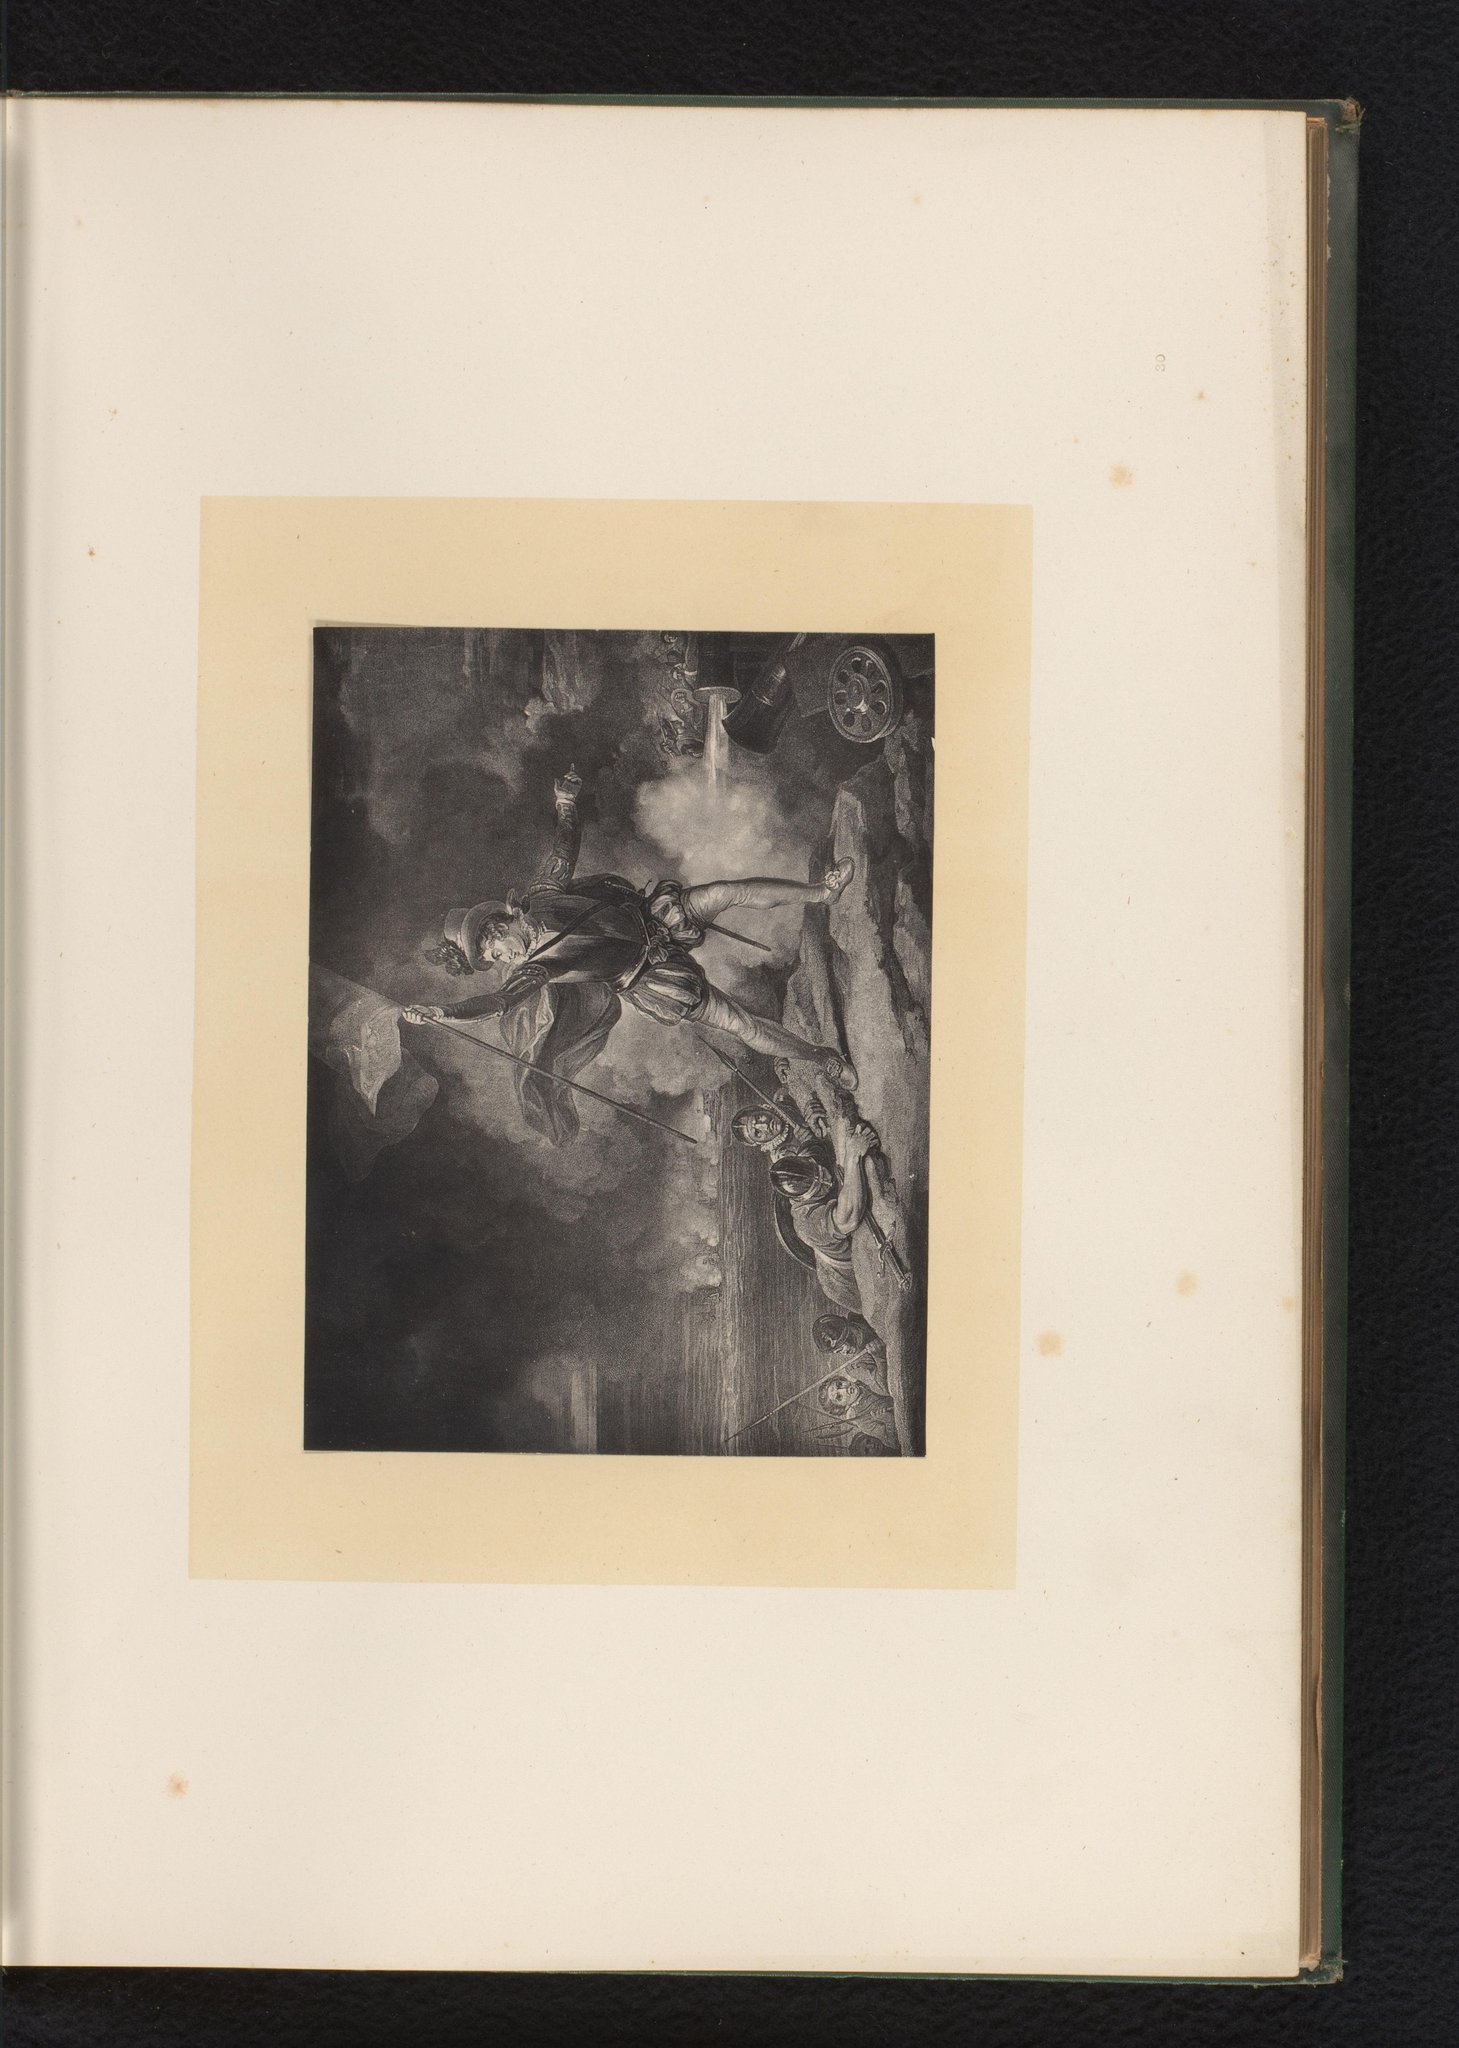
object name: photomechanical print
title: Reproductie van een gravure naar een schilderij van een scène uit As You Like It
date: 1874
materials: paper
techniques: woodburytype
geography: london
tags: (shakespeare, as you like it) specific works of literature (with author, title)